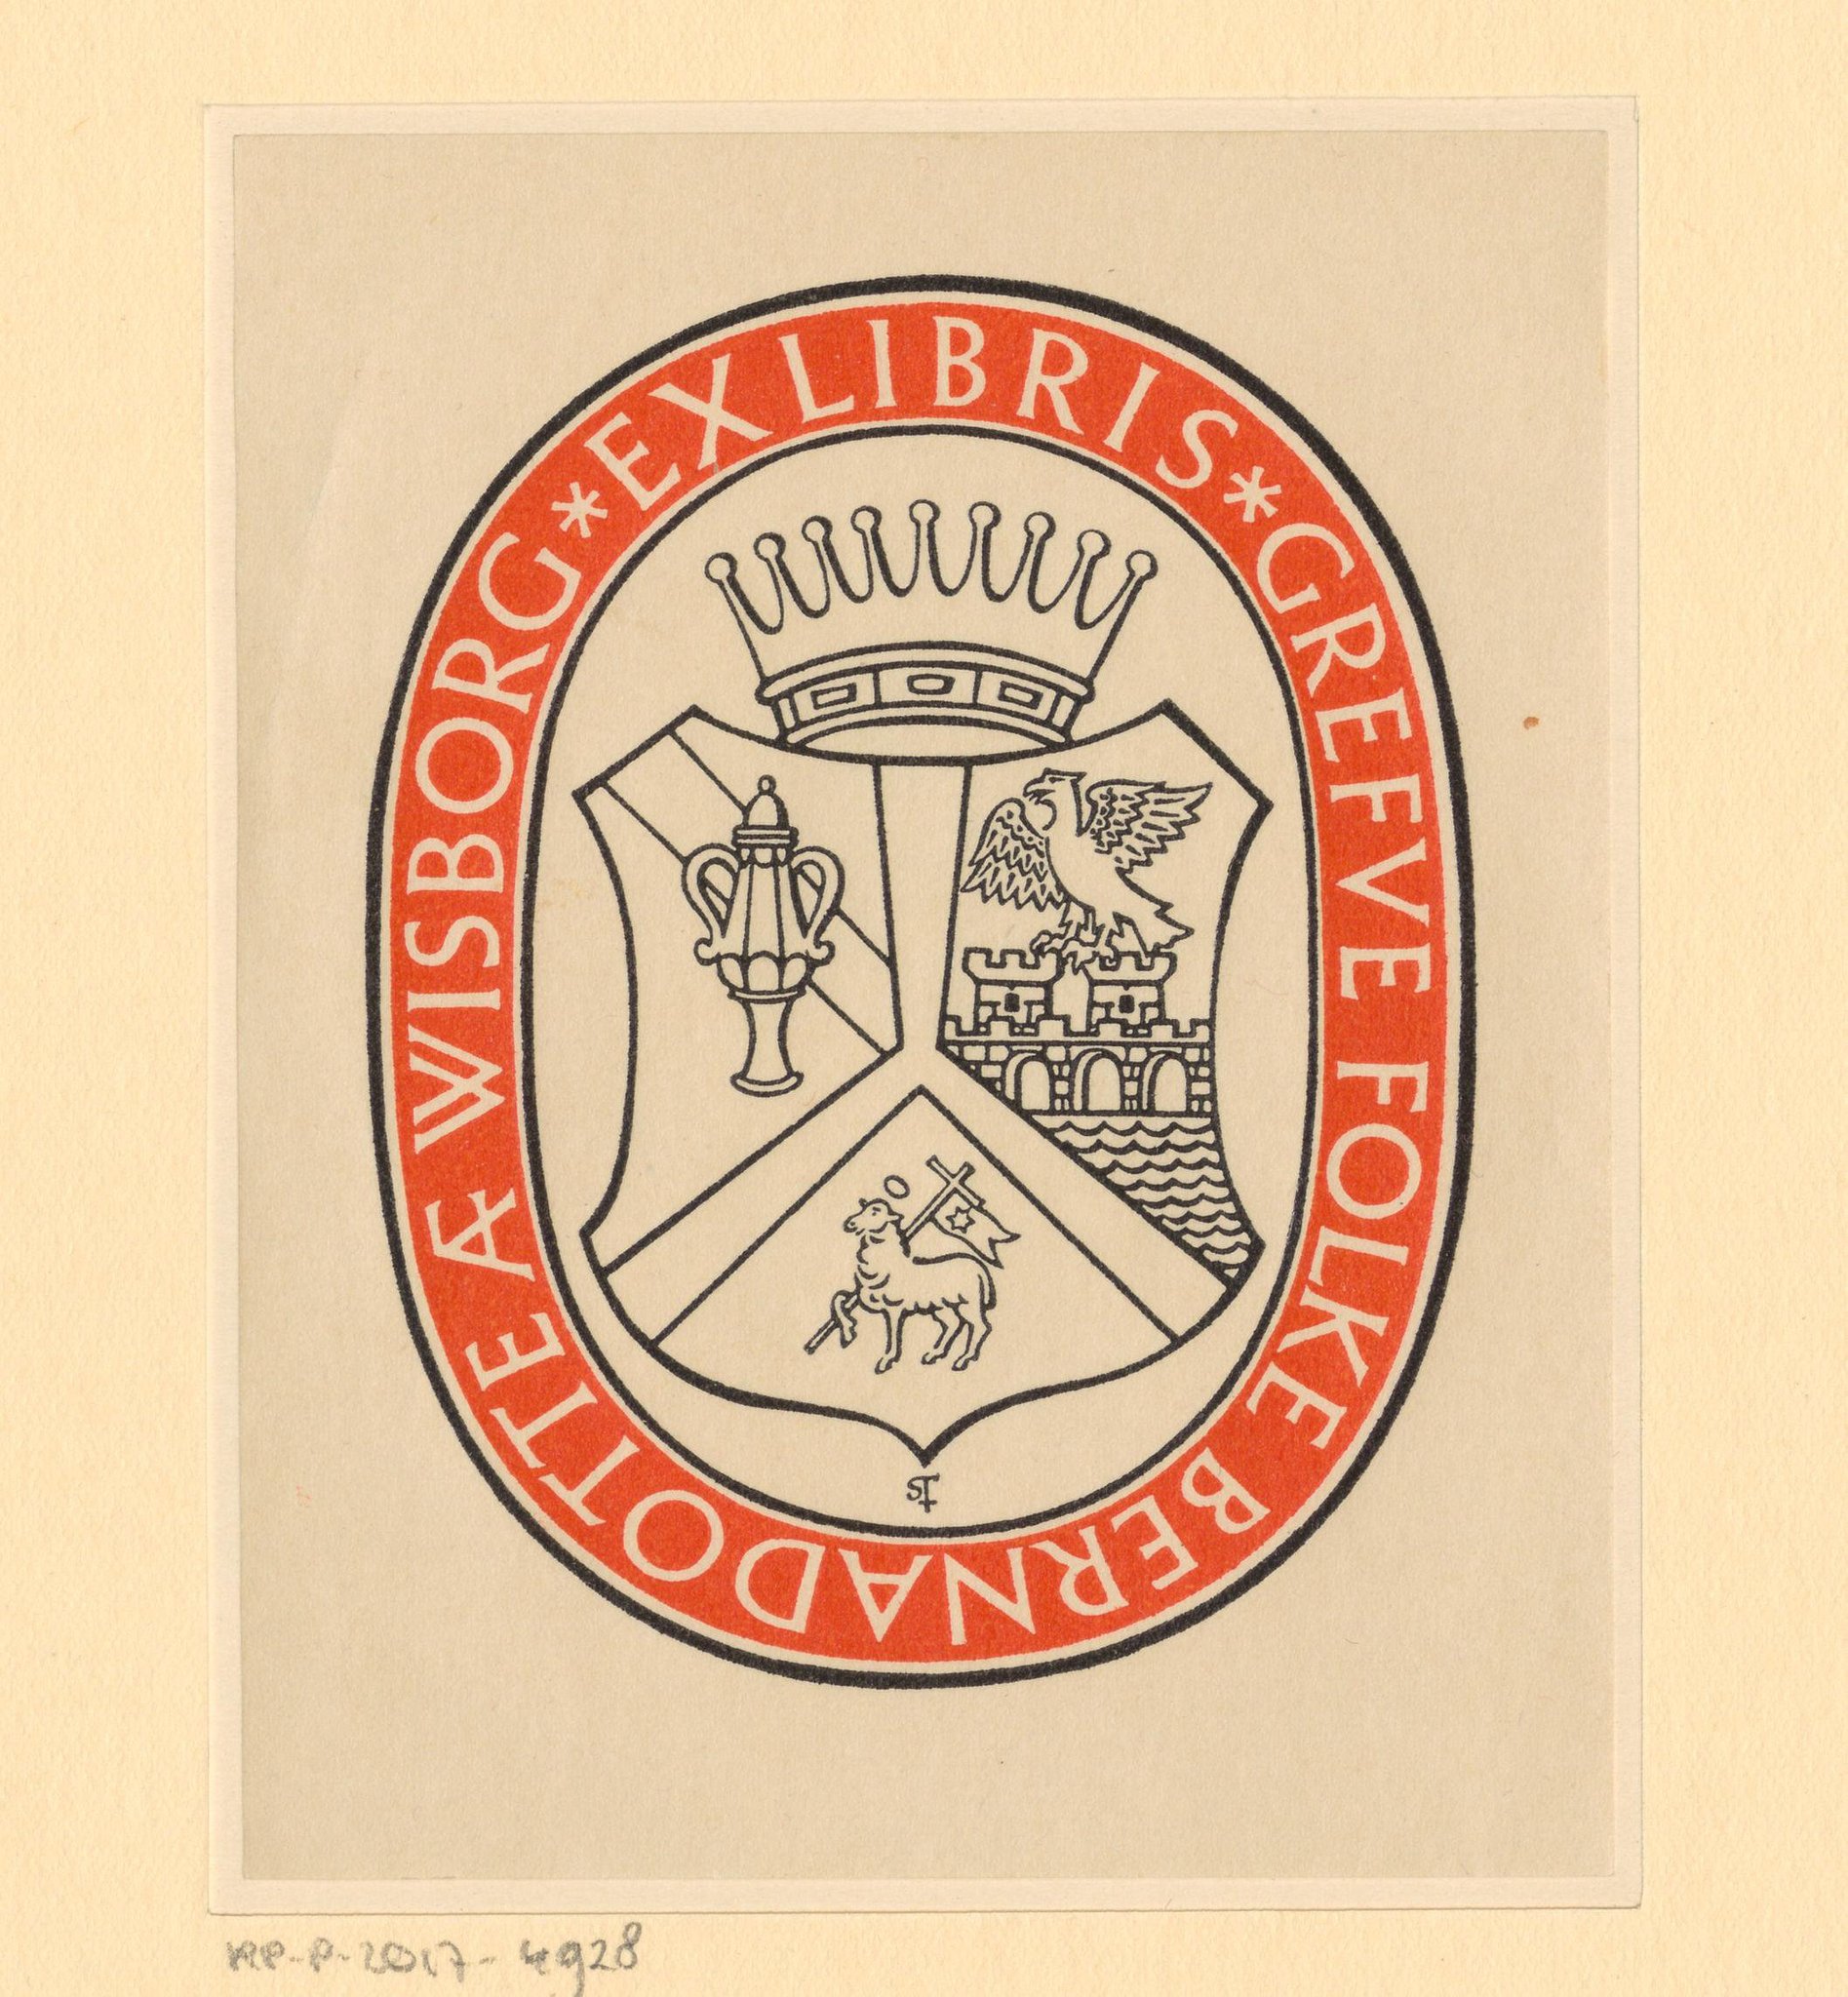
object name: bookplate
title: Ex libris van Folke Bernadotte af Wisborg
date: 1942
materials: paper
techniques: printing block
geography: germany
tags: armorial bearing, heraldry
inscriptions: inscription: ‘Hugo Steiner-Prag, cl. 1942’